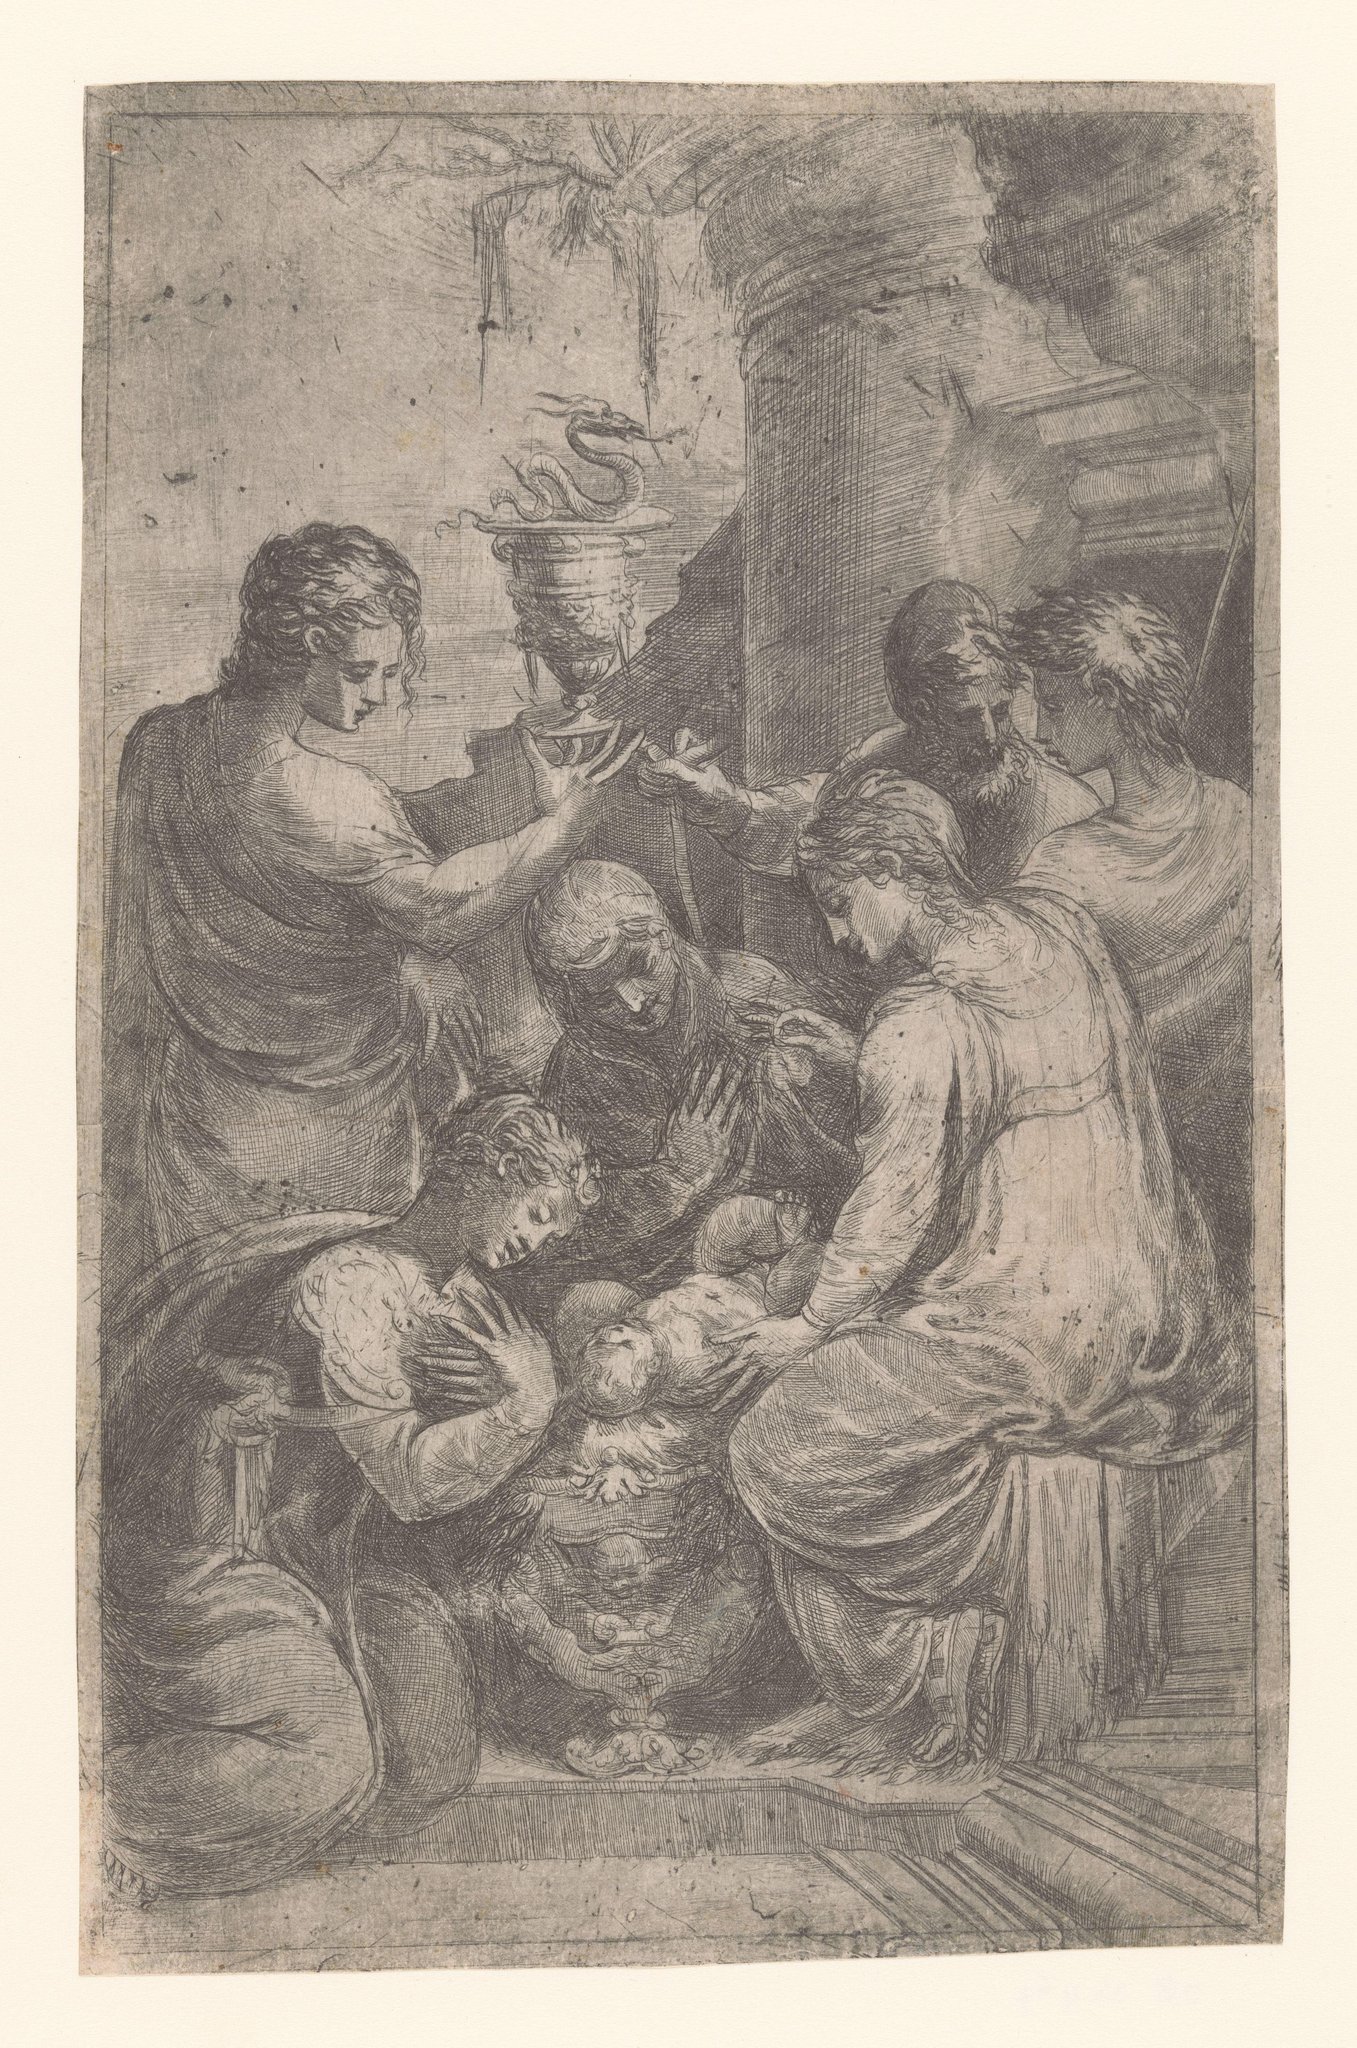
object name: print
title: Christus in de kribbe met heiligen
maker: schiavone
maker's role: draughtsman, painter, print maker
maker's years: 1500-1563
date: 1532-1563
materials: paper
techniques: etching, intaglio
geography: italy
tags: saints, christ-child together with others, female saints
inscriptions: collector's mark: Lugt 240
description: Het Christuskind ligt in een kribbe en wordt omringd door mannelijke en vrouwelijke heiligen. Links staat Johannes de Evangelist met een kelk met op het deksel een slang.